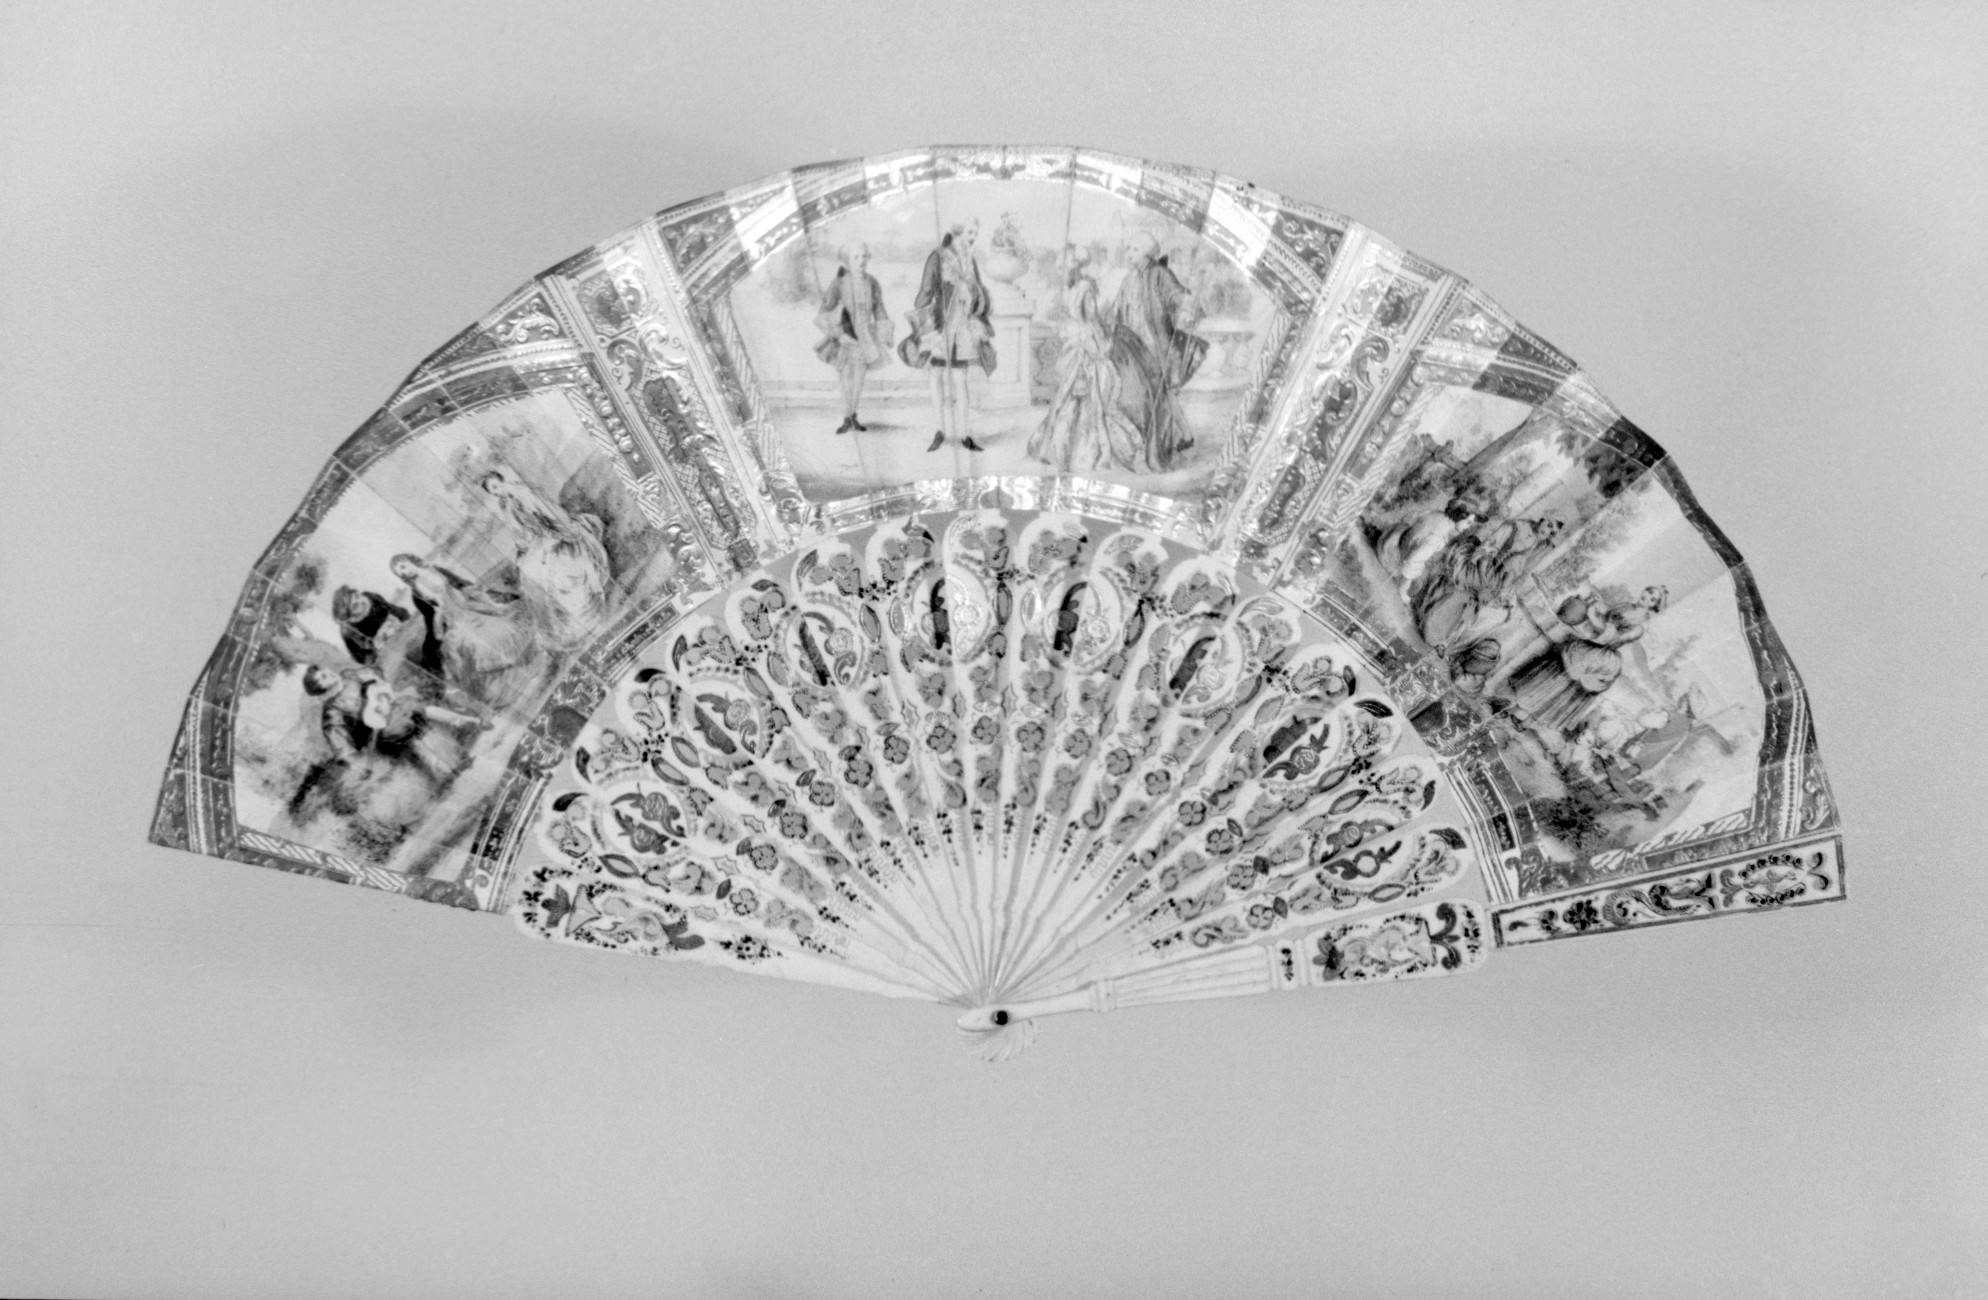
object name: fan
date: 1834-1866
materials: gilt, glass, gold, ivory, paint, paper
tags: men,women